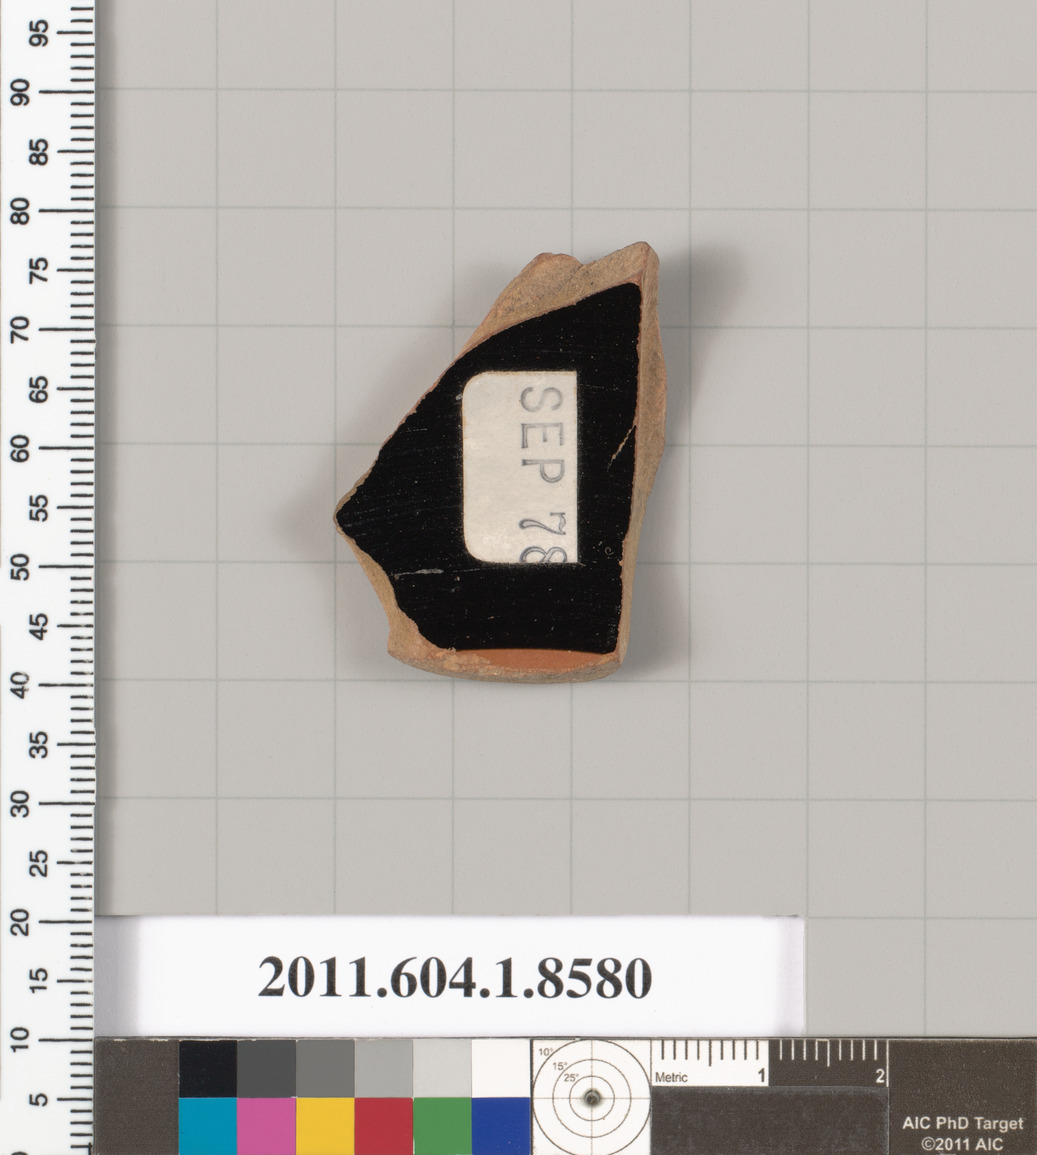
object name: kylix fragment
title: Terracotta fragment of a stemless kylix (drinking cup)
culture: greek, attic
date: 475-451 BCE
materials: terracotta